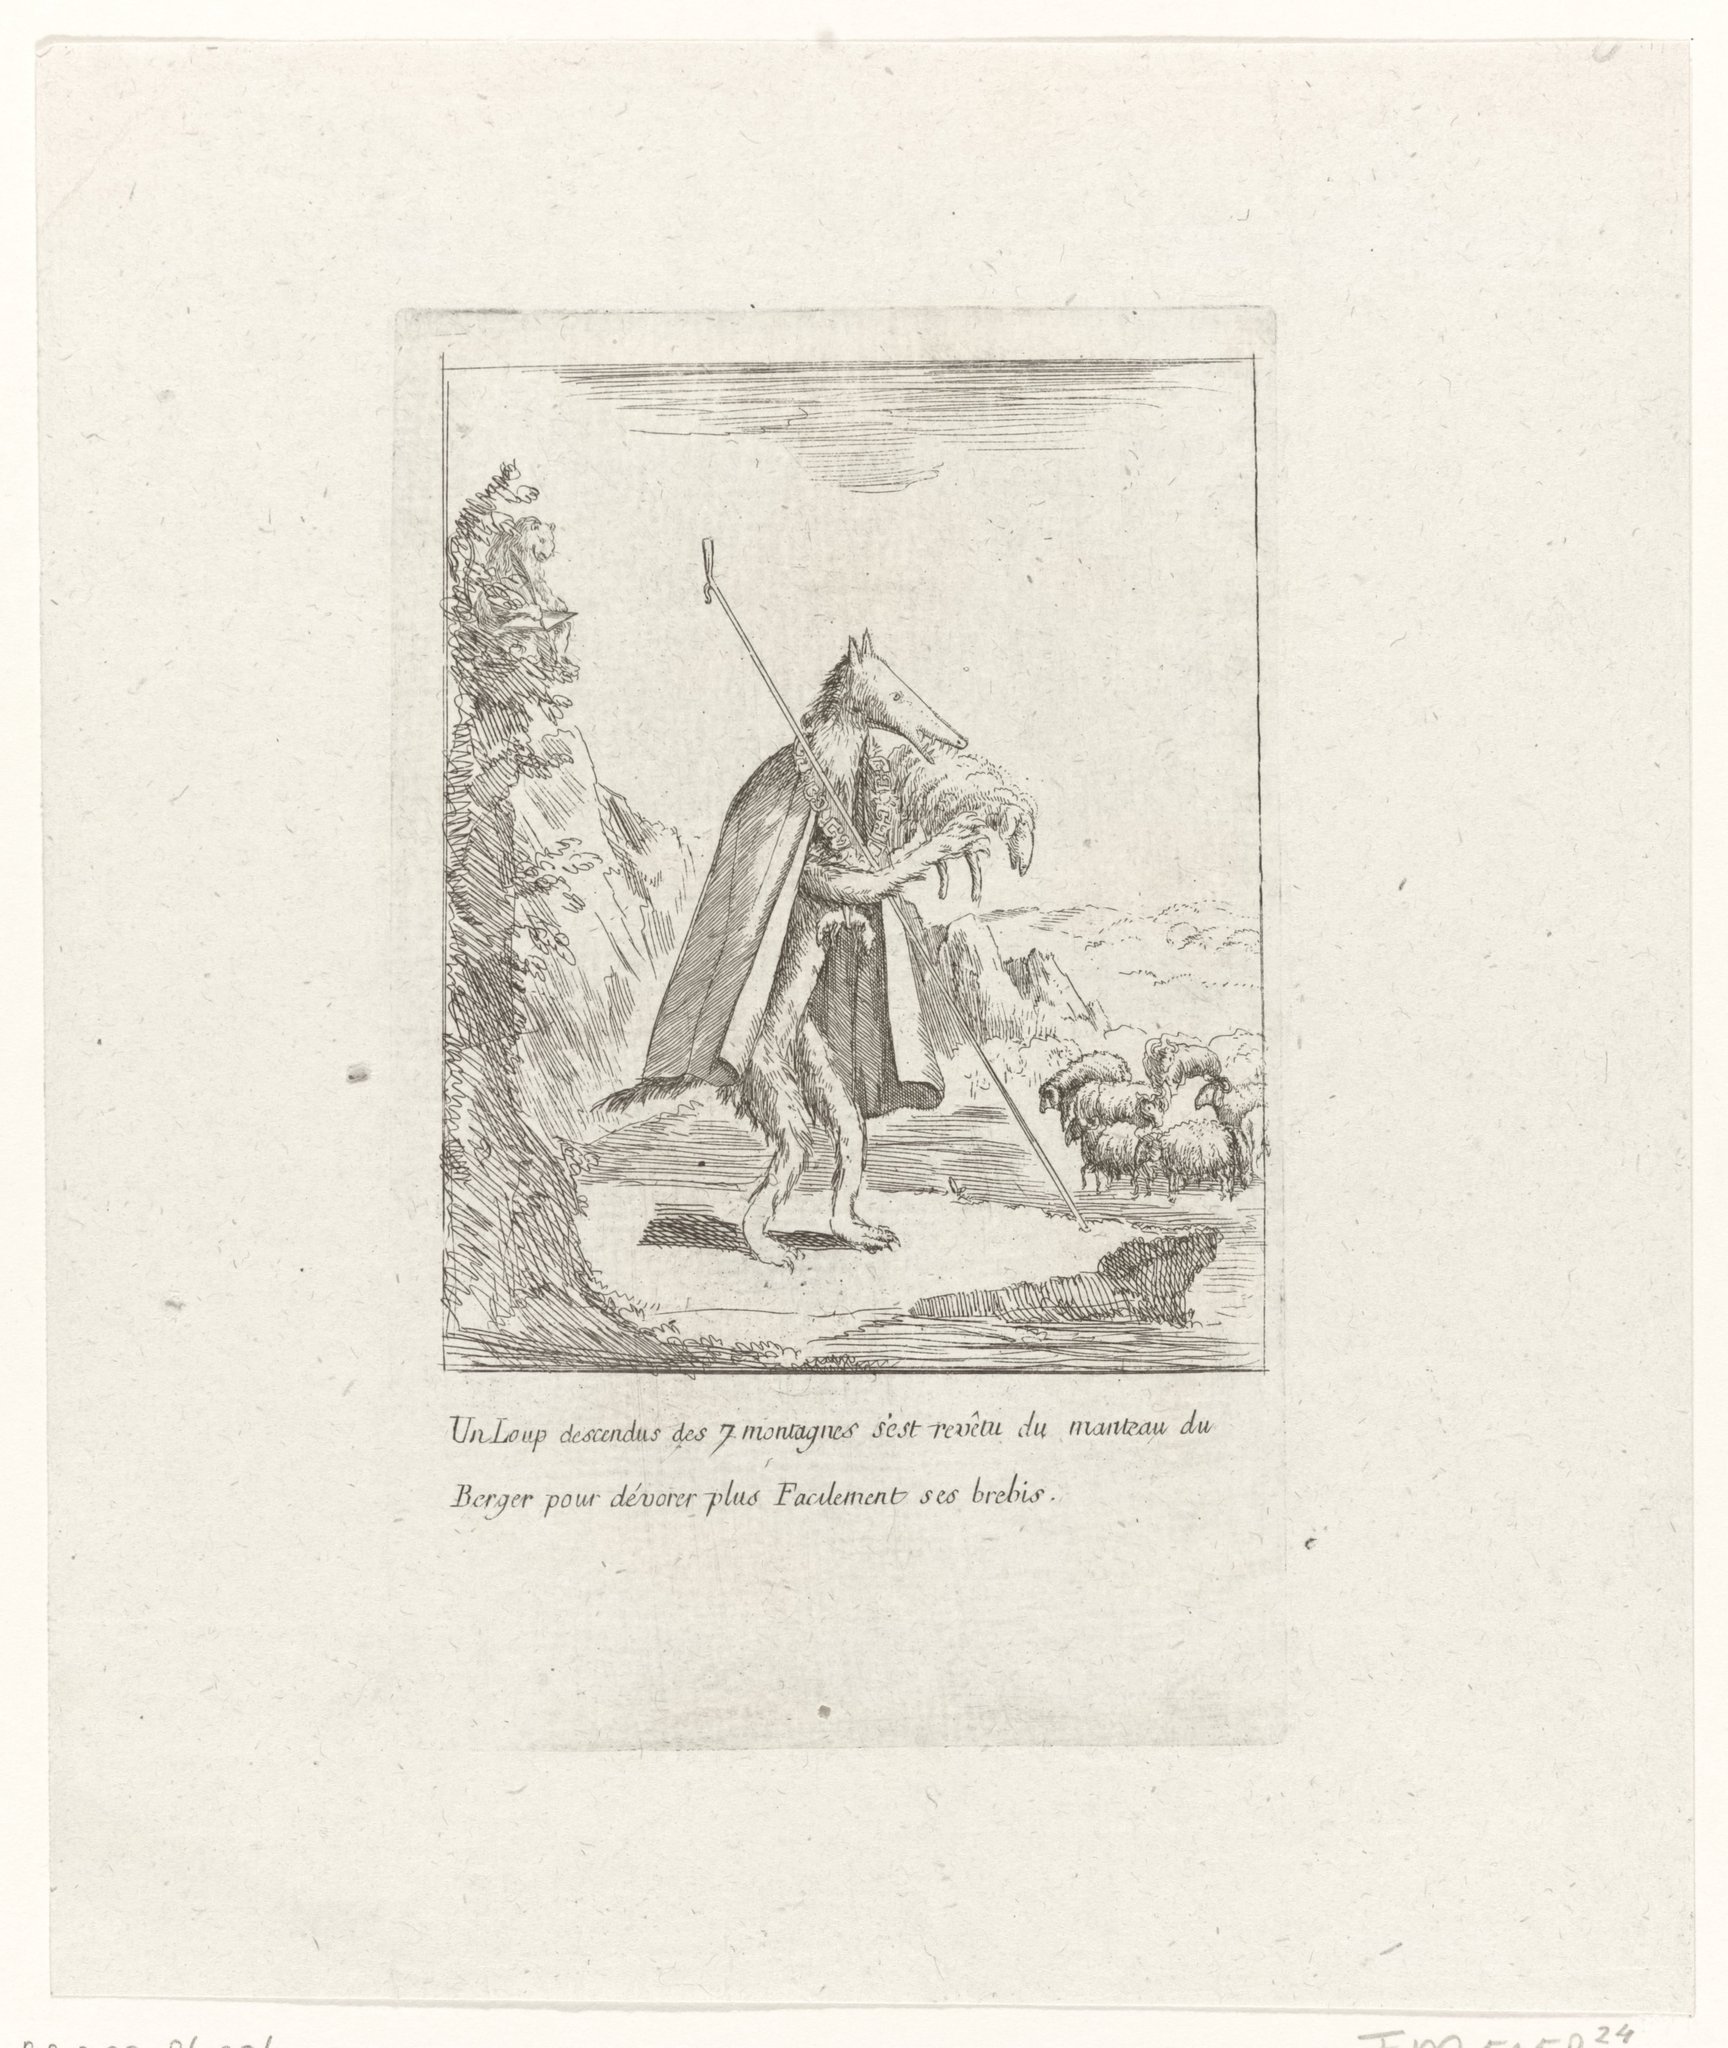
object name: print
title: Brabantse Omwenteling, 1787-1790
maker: Anonymous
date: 1787-1790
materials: paper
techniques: etching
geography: southern netherlands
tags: jozef ii (duits keizer), animals acting as human beings, wolf clothed as shepherd ~ parable of the good shepherd, brabant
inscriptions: collector's mark: Lugt 2228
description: Spotprent op de Oostenrijkse keizer Jozef II, hier in de gedaante van een wolf met het ordeteken van het Gulden Vlies die vermomd als een herder op het punt staat een schaap te verslinden. Gerelateeerd aan 12 augustus 1789. Met onderschrift van 2 regels in het Frans. Onderdeel van een grote groep van prenten betrekking hebbend op de gebeurtenissen van de Brabantse Omwenteling en de periode 1787-1790.